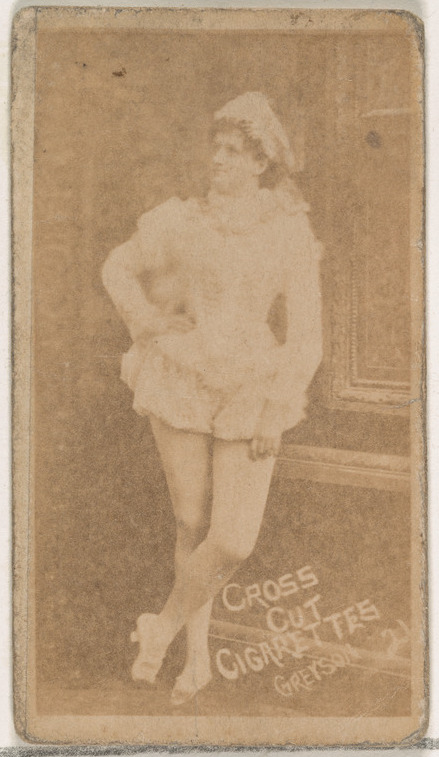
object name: print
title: Card Number 21, Greyson, from the Actors and Actresses series (N145-1) issued by Duke Sons & Co. to promote Cross Cut Cigarettes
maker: w. duke, sons & co.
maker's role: publisher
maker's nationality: american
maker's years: 1870-1920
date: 1880-1889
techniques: albumen silver print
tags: portraits,women,actresses